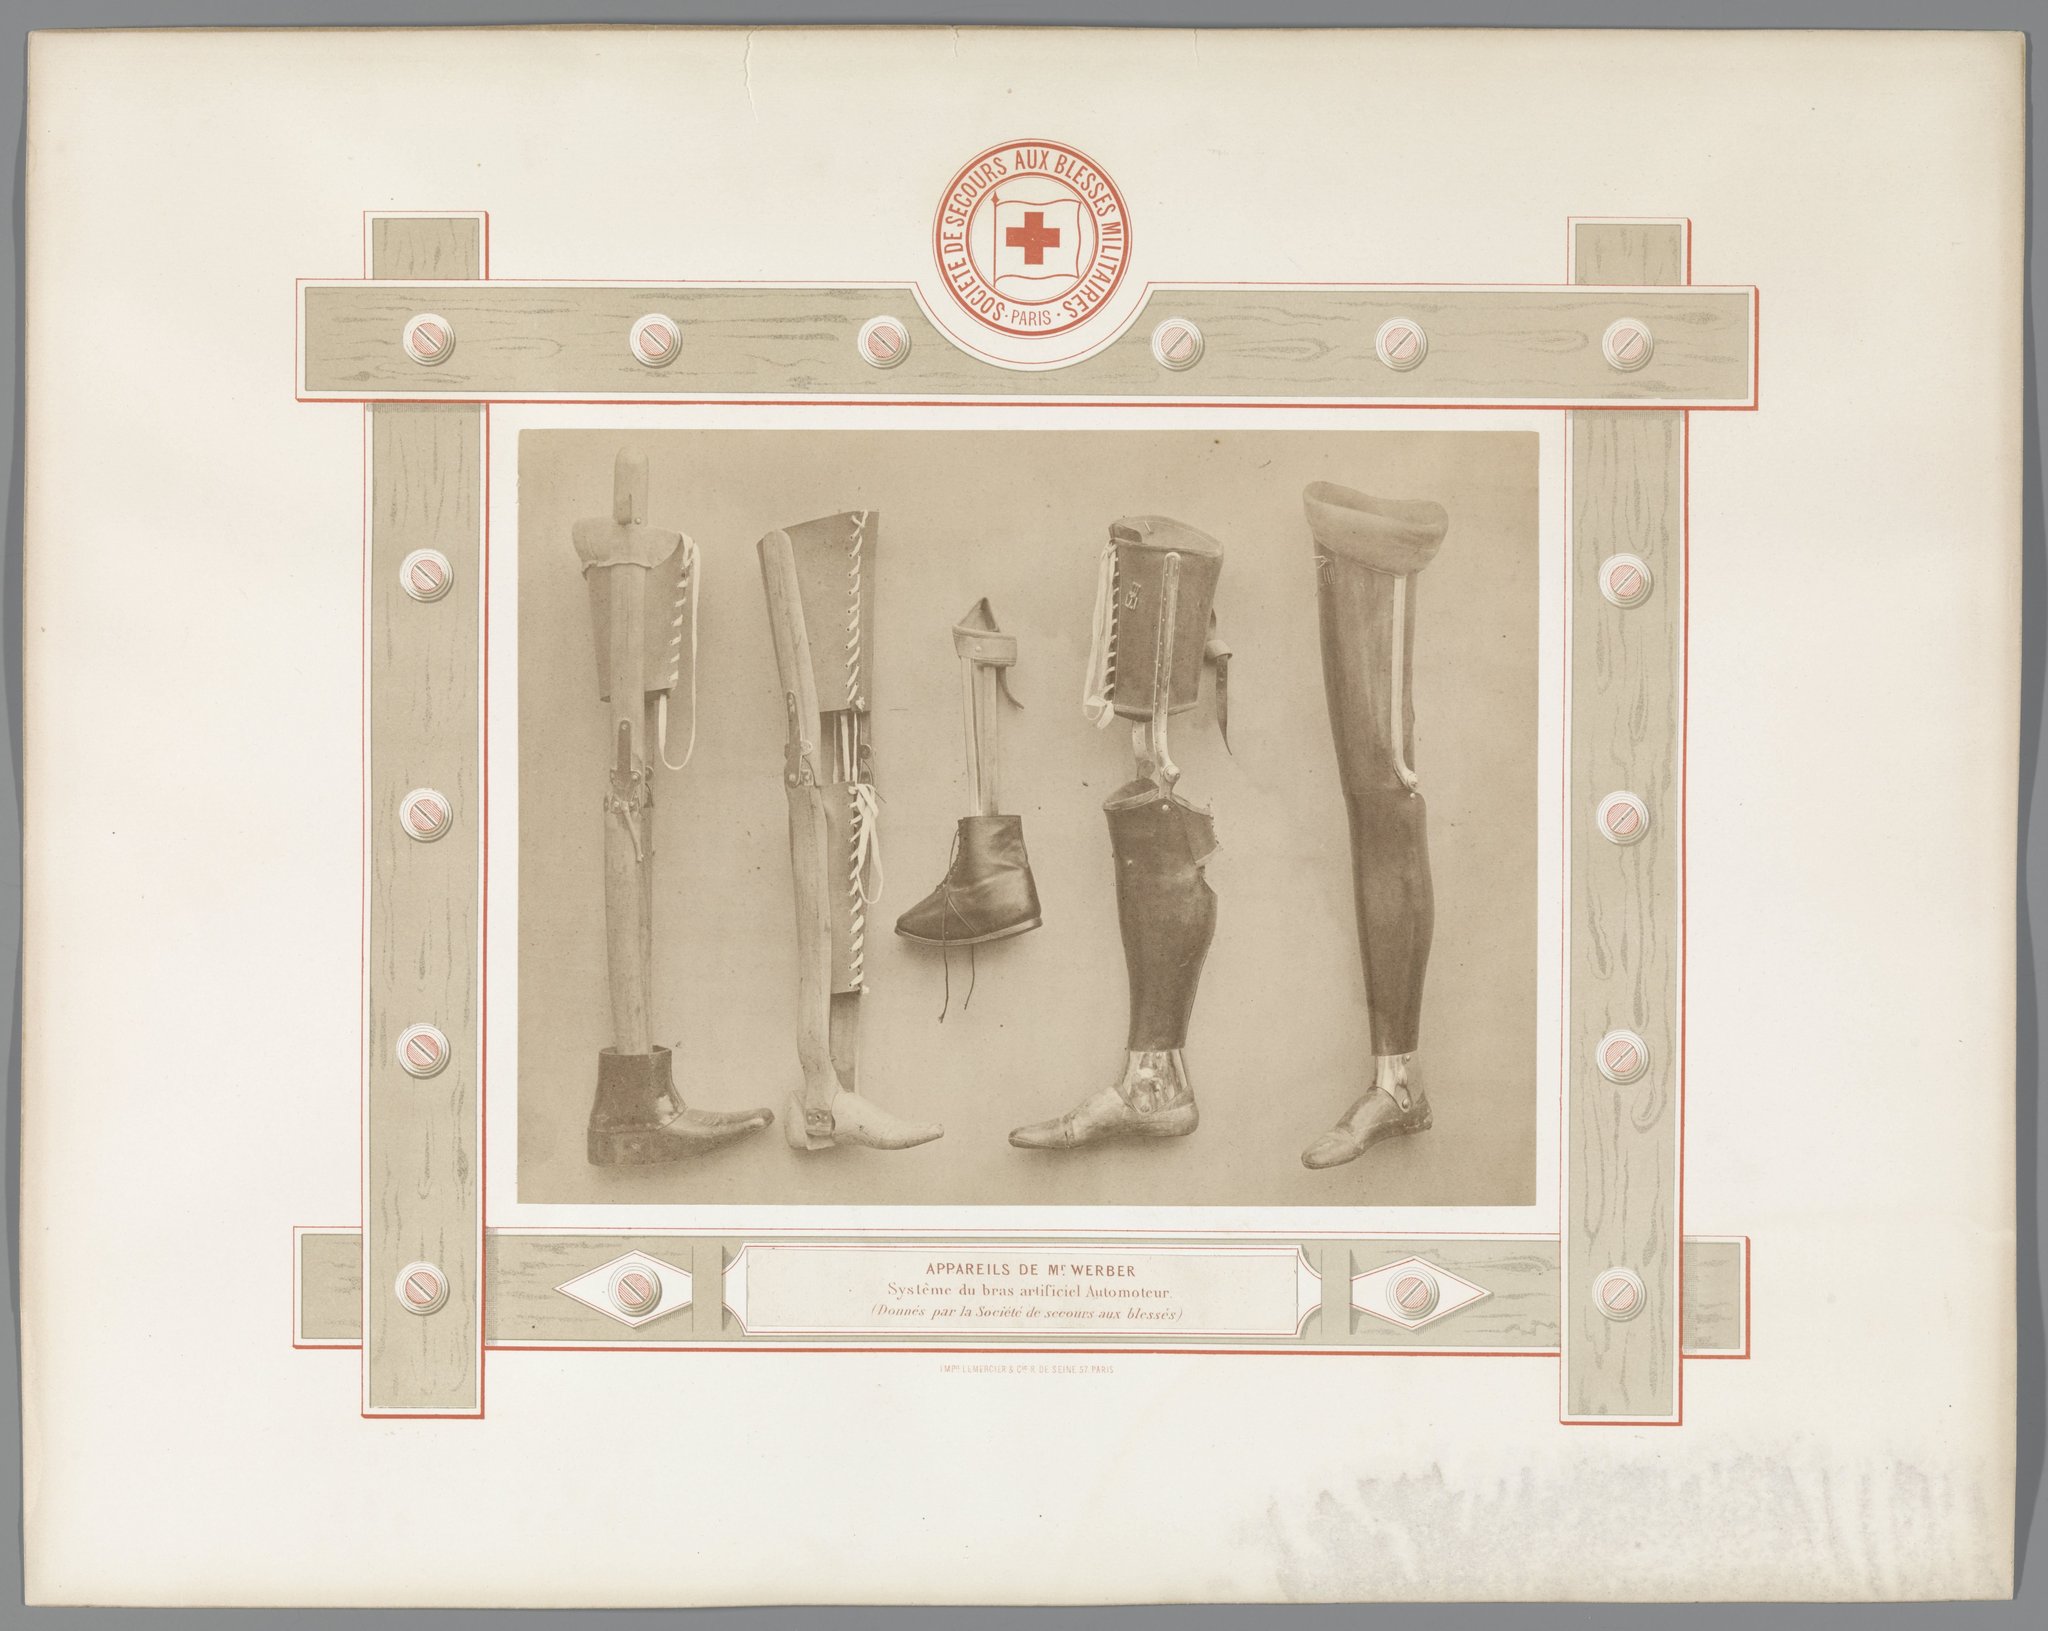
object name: photograph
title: Leg Prostheses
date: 1870-1871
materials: cardboard, photographic support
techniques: albumen print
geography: paris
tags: wooden leg, prosthesis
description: The Société de Secours aux Blessés Militaires endeavoured from 1864 to aid wounded soldiers by providing them with leg prostheses and other items. This photograph belongs to a larger series illustrating prostheses, ambulances, stretchers, and other equipment. They were taken around the time of the Franco-Prussian War of 1870-1871. With the photographs the Société possibly wanted to draw attention to its charitable deeds and raise money.